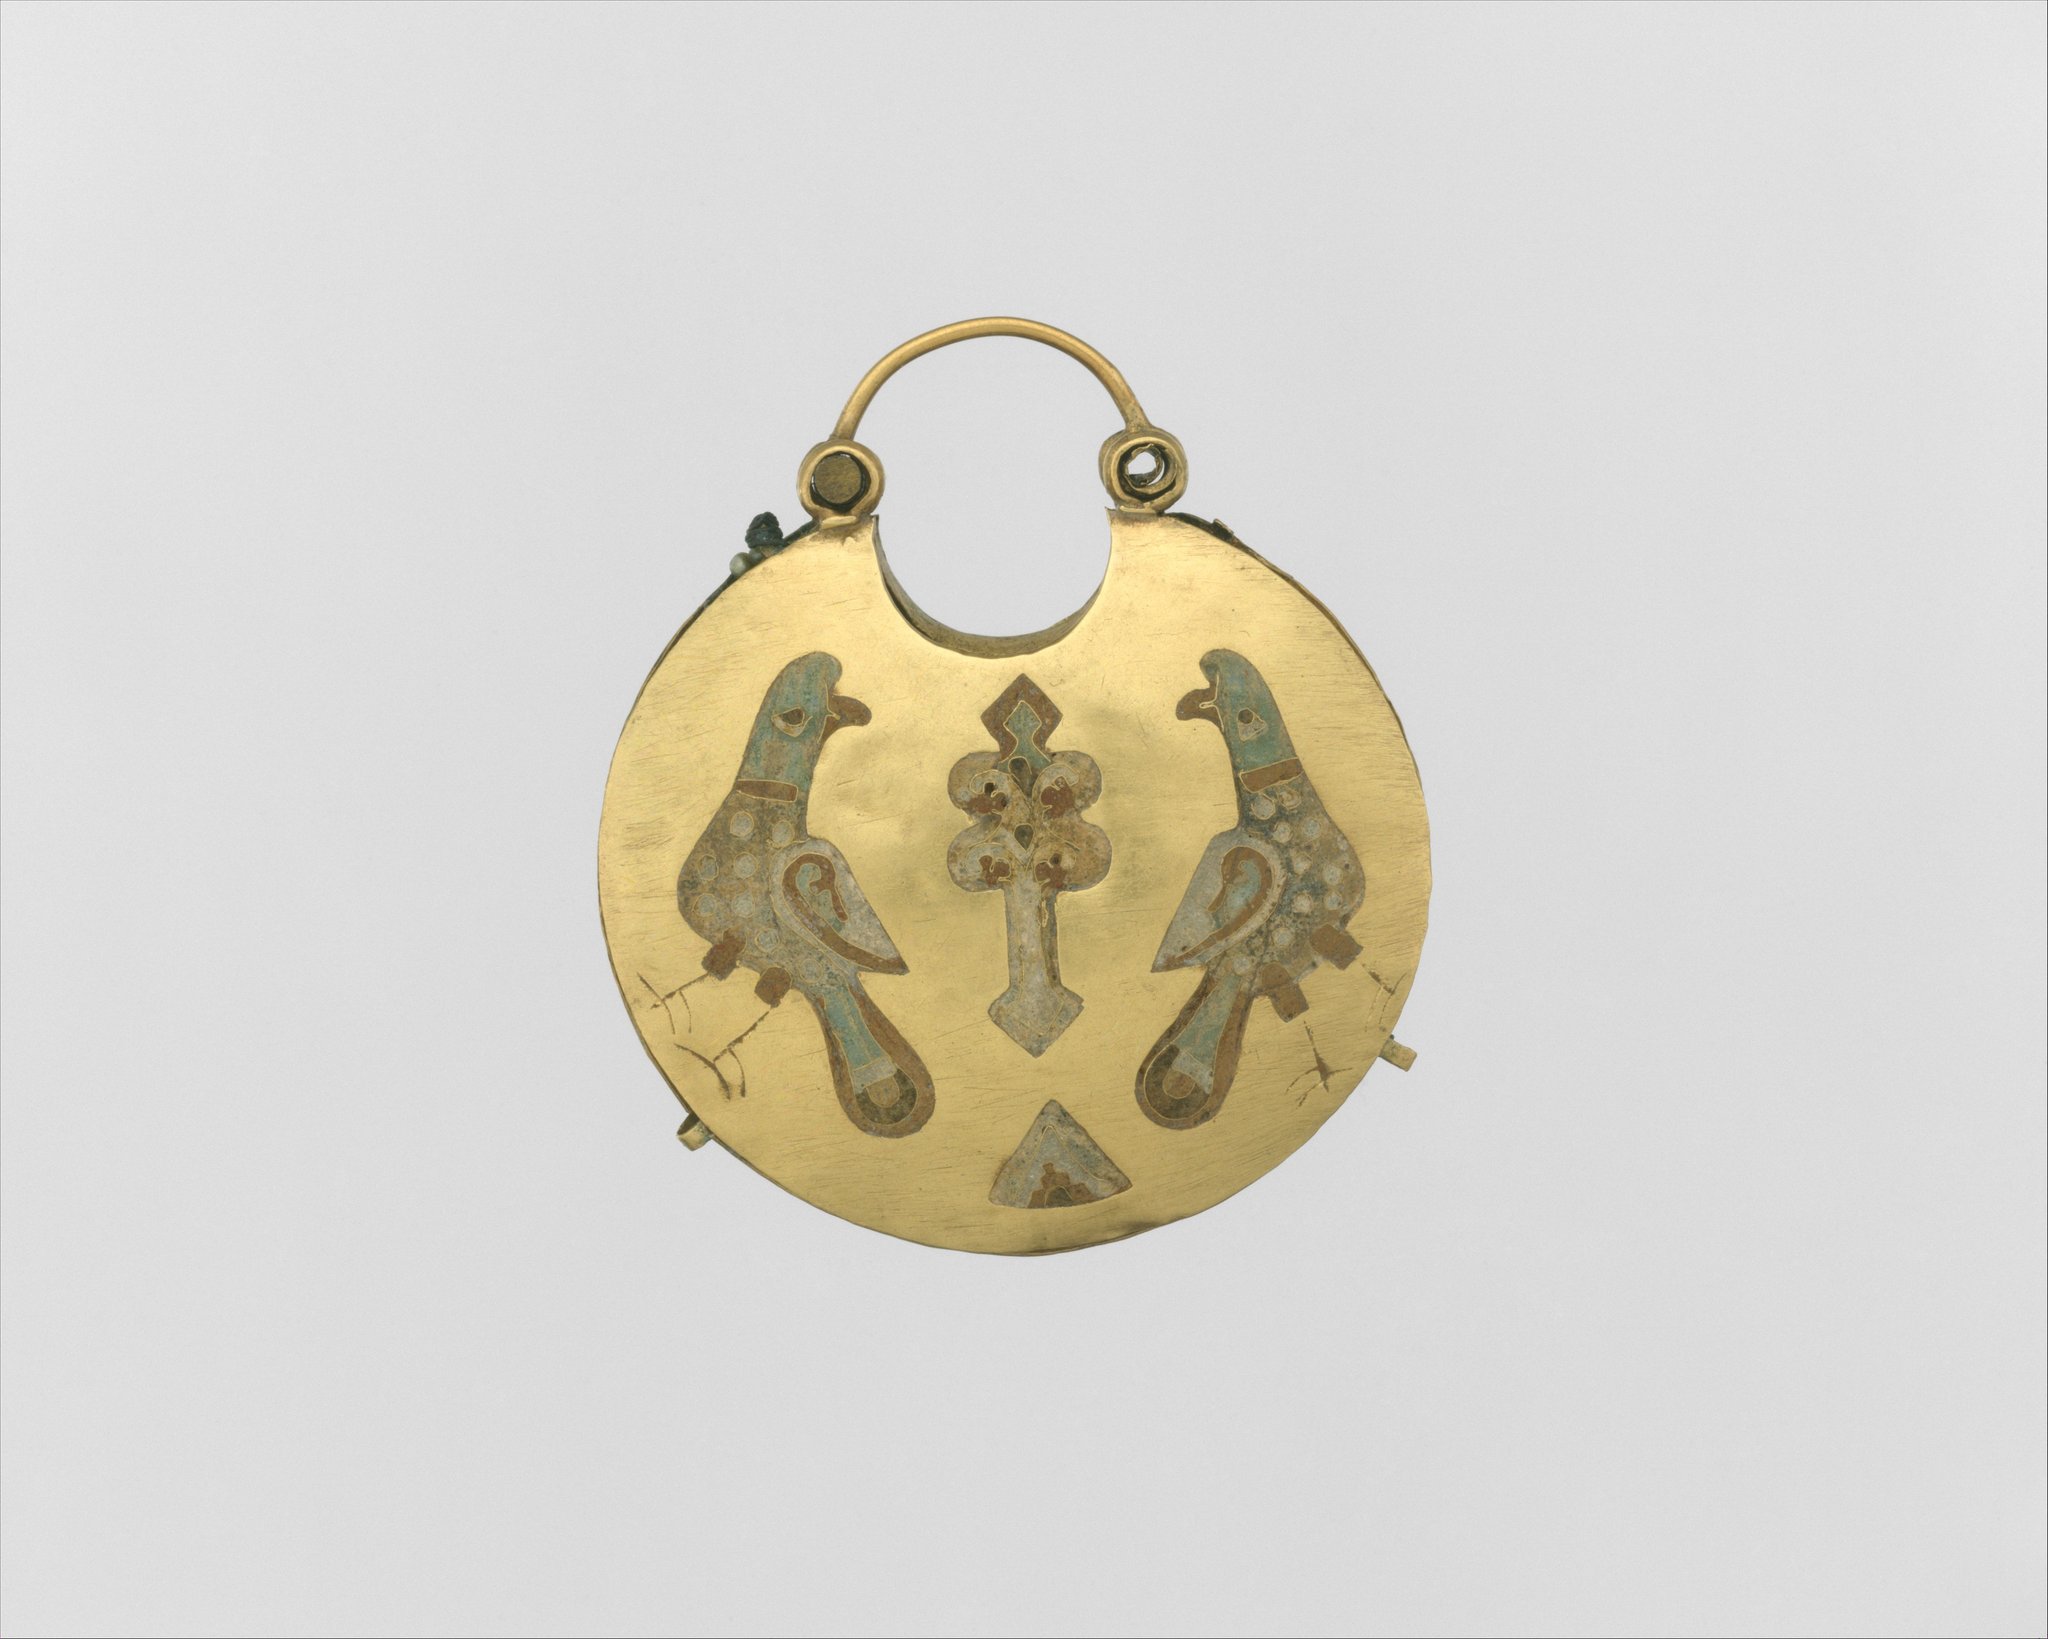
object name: temple pendant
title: One of a Pair of Temple Pendants, with Two Birds Flanking a Tree of Life (front) and Leaf and Rosette Motifs (back)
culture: kyivan rus’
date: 1001-1200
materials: enamel, gold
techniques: enamel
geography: ukraine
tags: birds